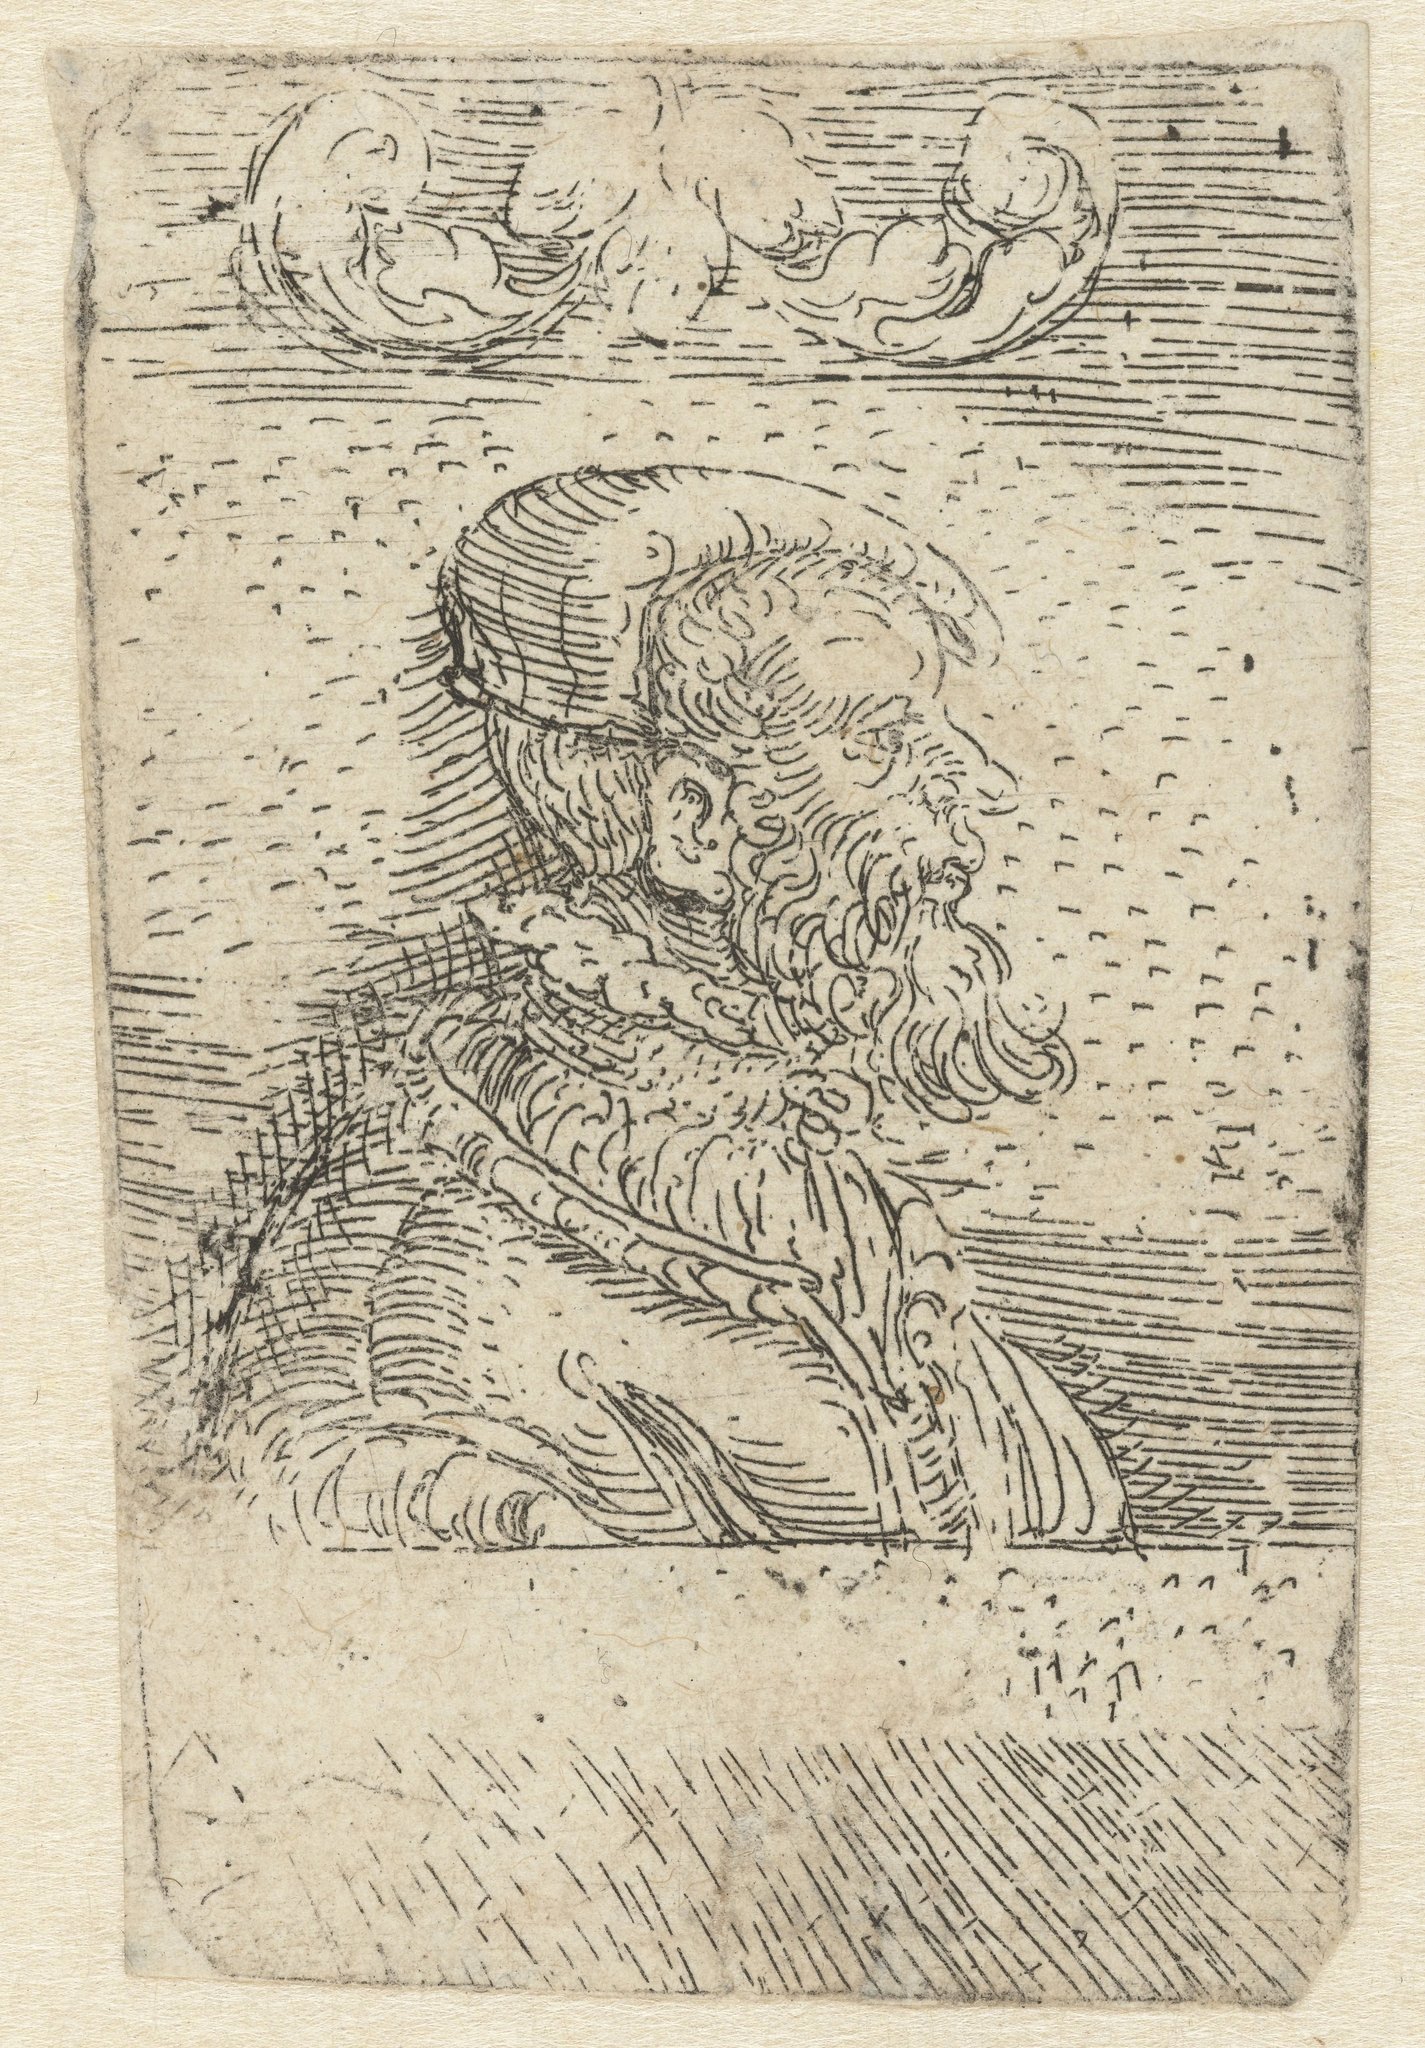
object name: print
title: Portret van een man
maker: nicolaas hogenberg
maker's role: draughtsman, painter, print maker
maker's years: 1500-1539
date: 1500-1539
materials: paper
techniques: etching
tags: historical persons (portraits and scenes from the life) (+ (full) bust portrait)